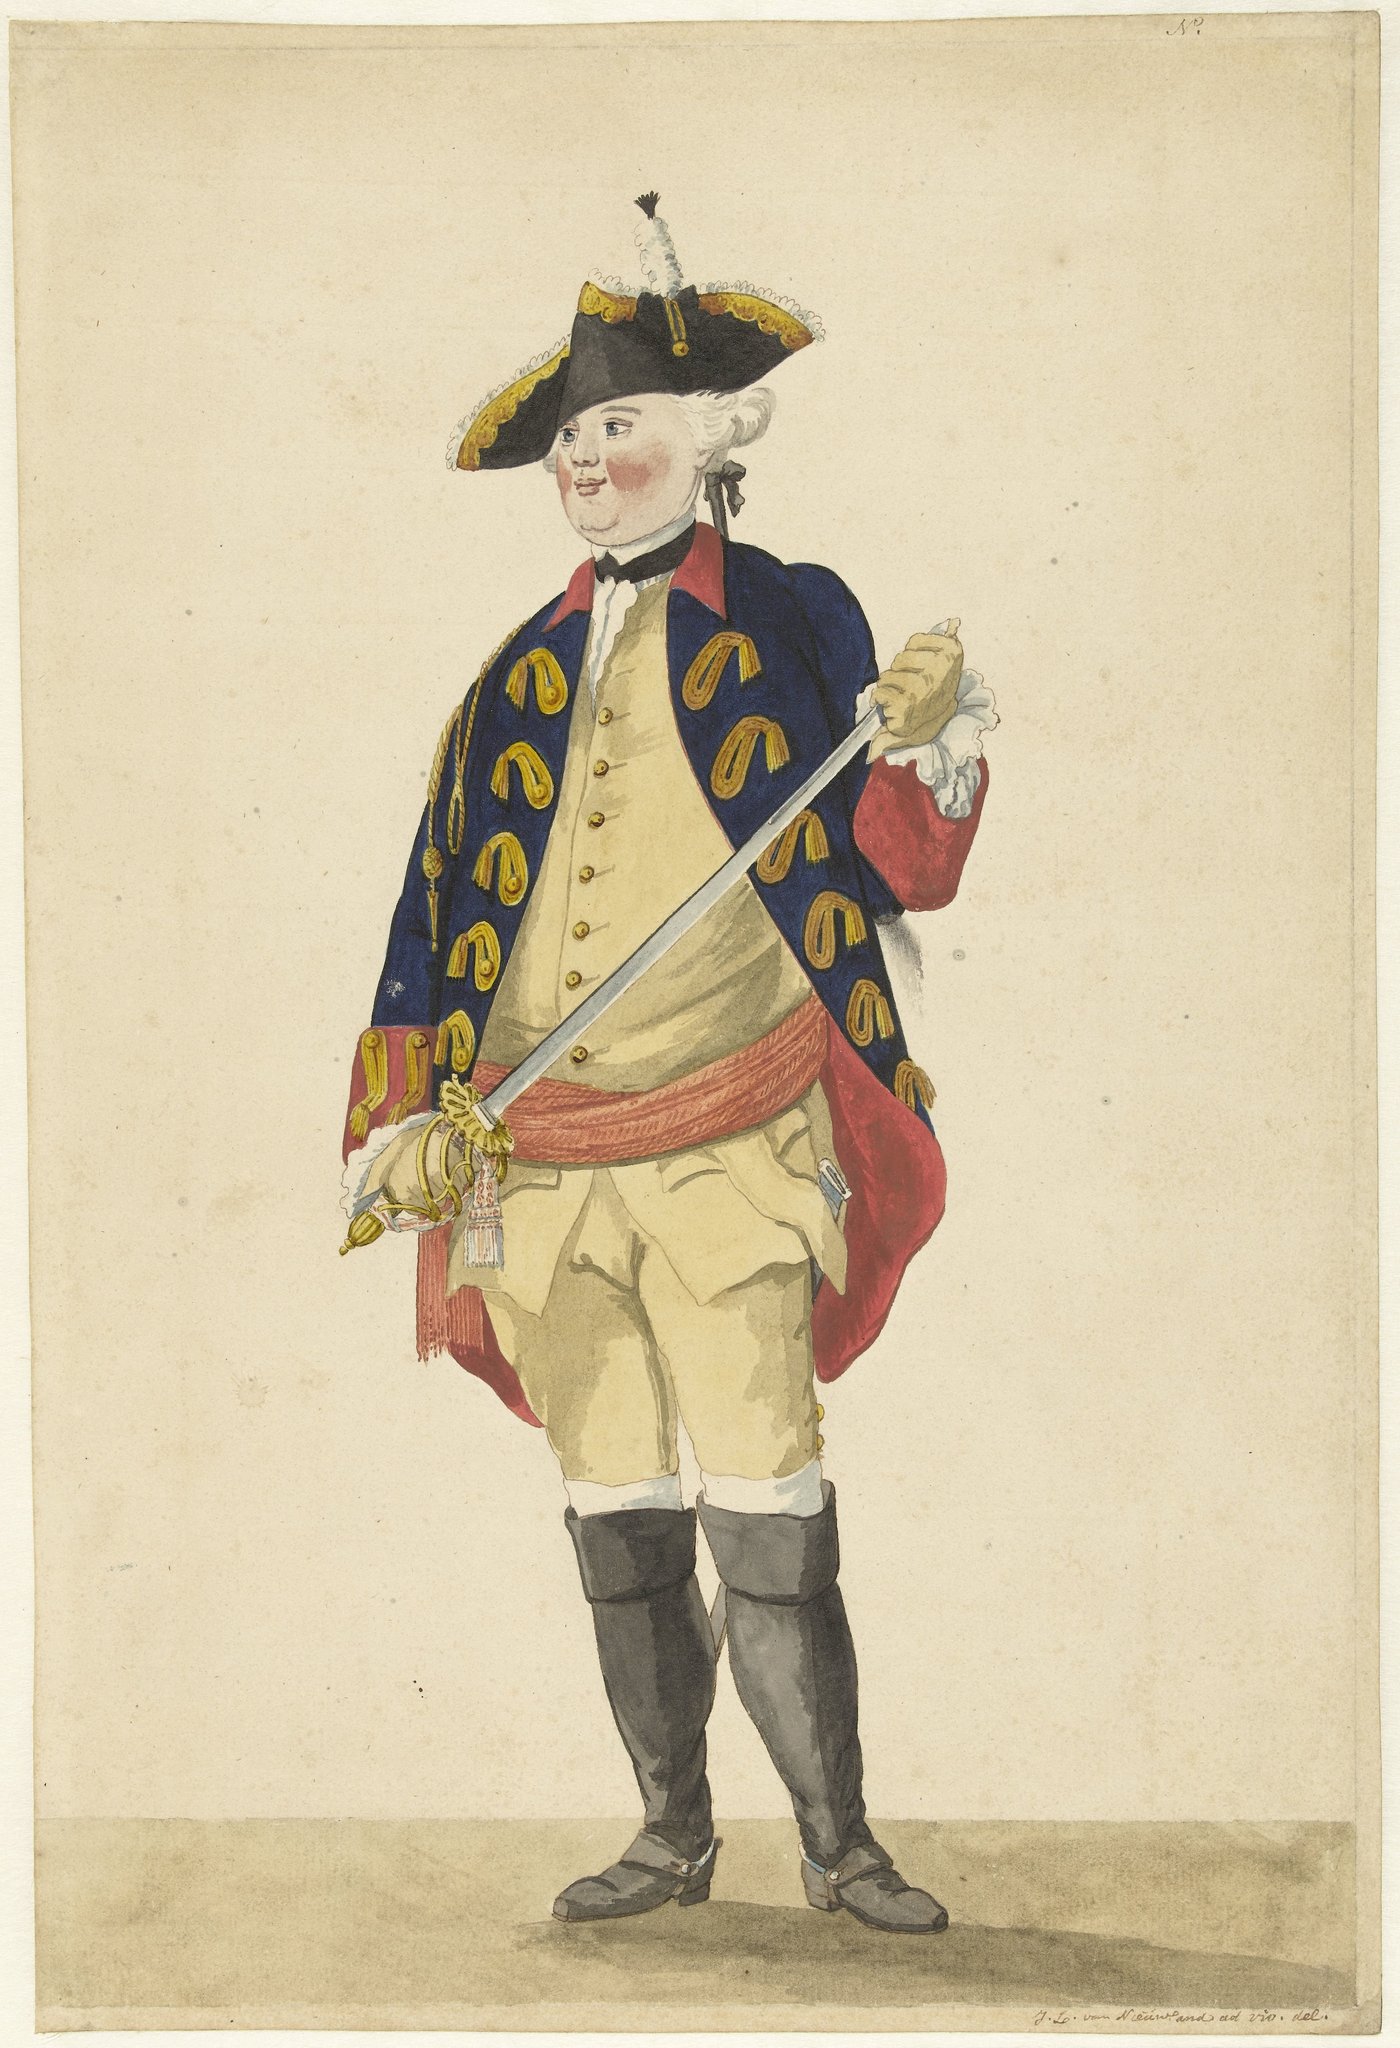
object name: kostuumstudie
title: Costumes van het hof van Willem V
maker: isaac lodewijk la fargue van nieuwland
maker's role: draughtsman, painter, print maker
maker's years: 1726-1805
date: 1766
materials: ink, paper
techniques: brush, pen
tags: william v (prince of orange)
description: Blad 15 uit serie van 24 tekeningen met leden van de hofhouding van stadhouder Willem V.